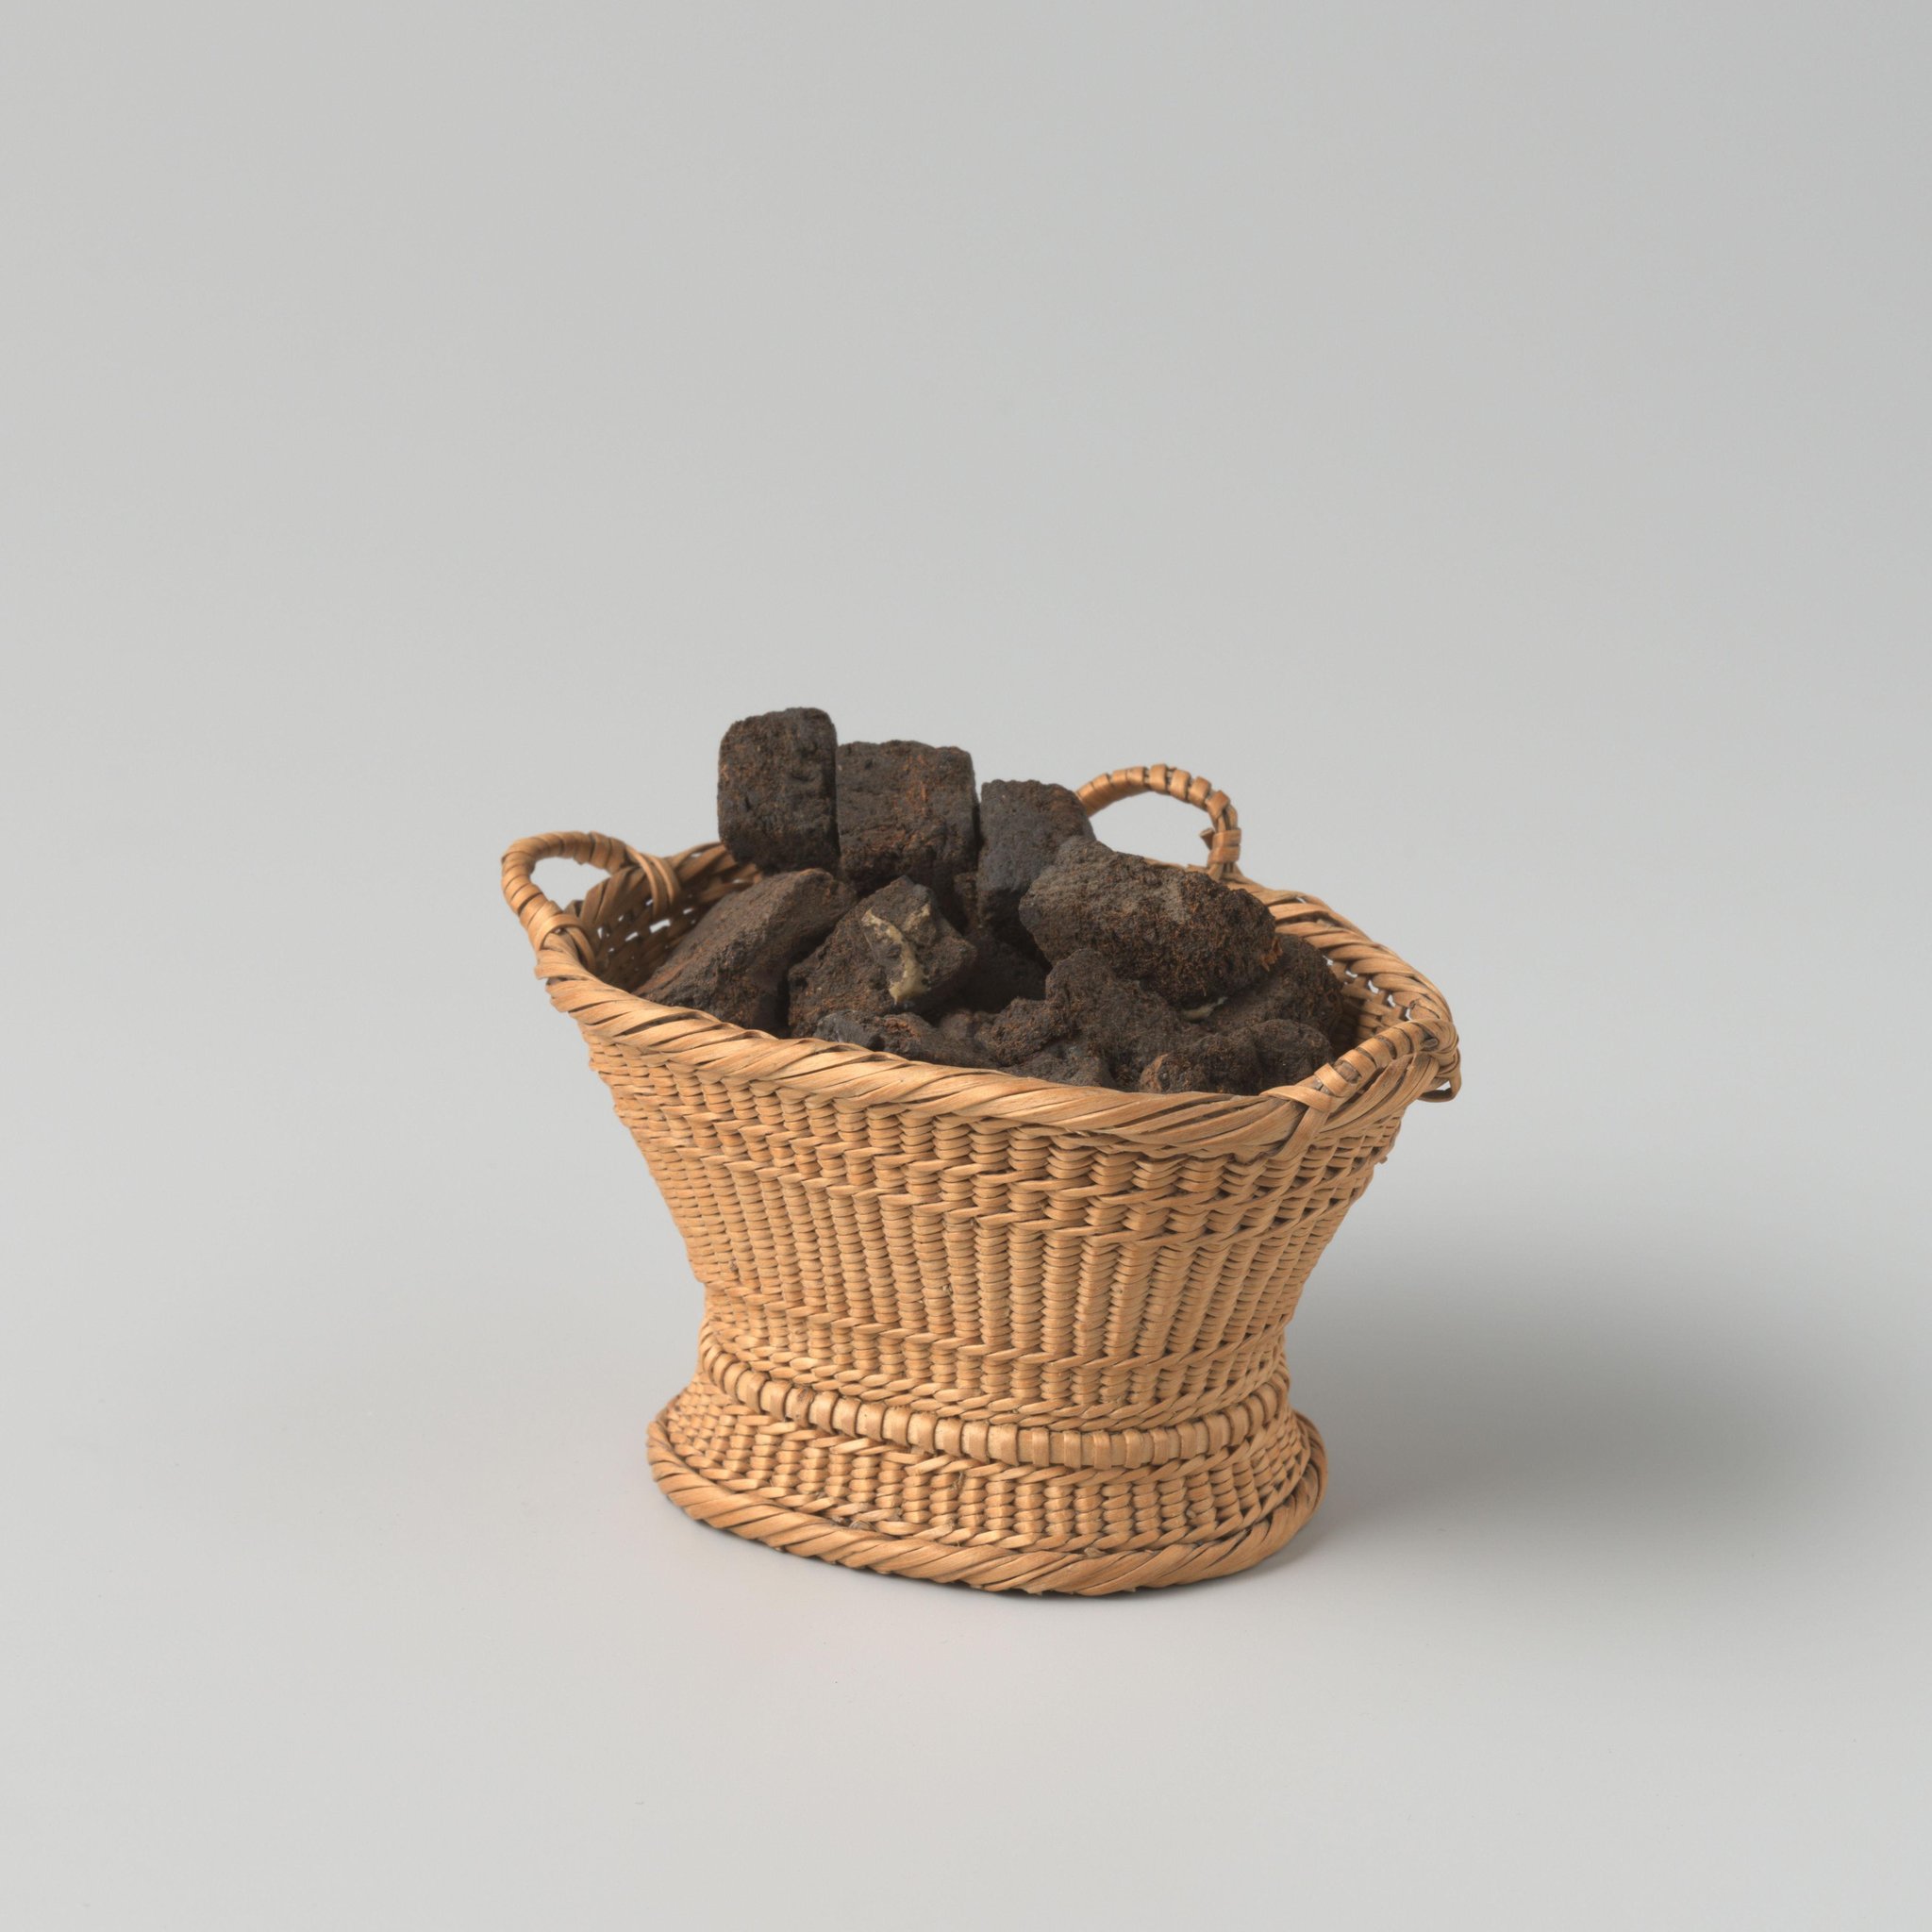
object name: basket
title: Ovale turfmand gevuld met turfbriketten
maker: Anonymous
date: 1690-1710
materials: plant material, peat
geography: halle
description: Ovale turfmand van gespleten wilgenteen, fijnscheenwerk. De mand heeft driehandvatten en is gevuld met turfbriketten.